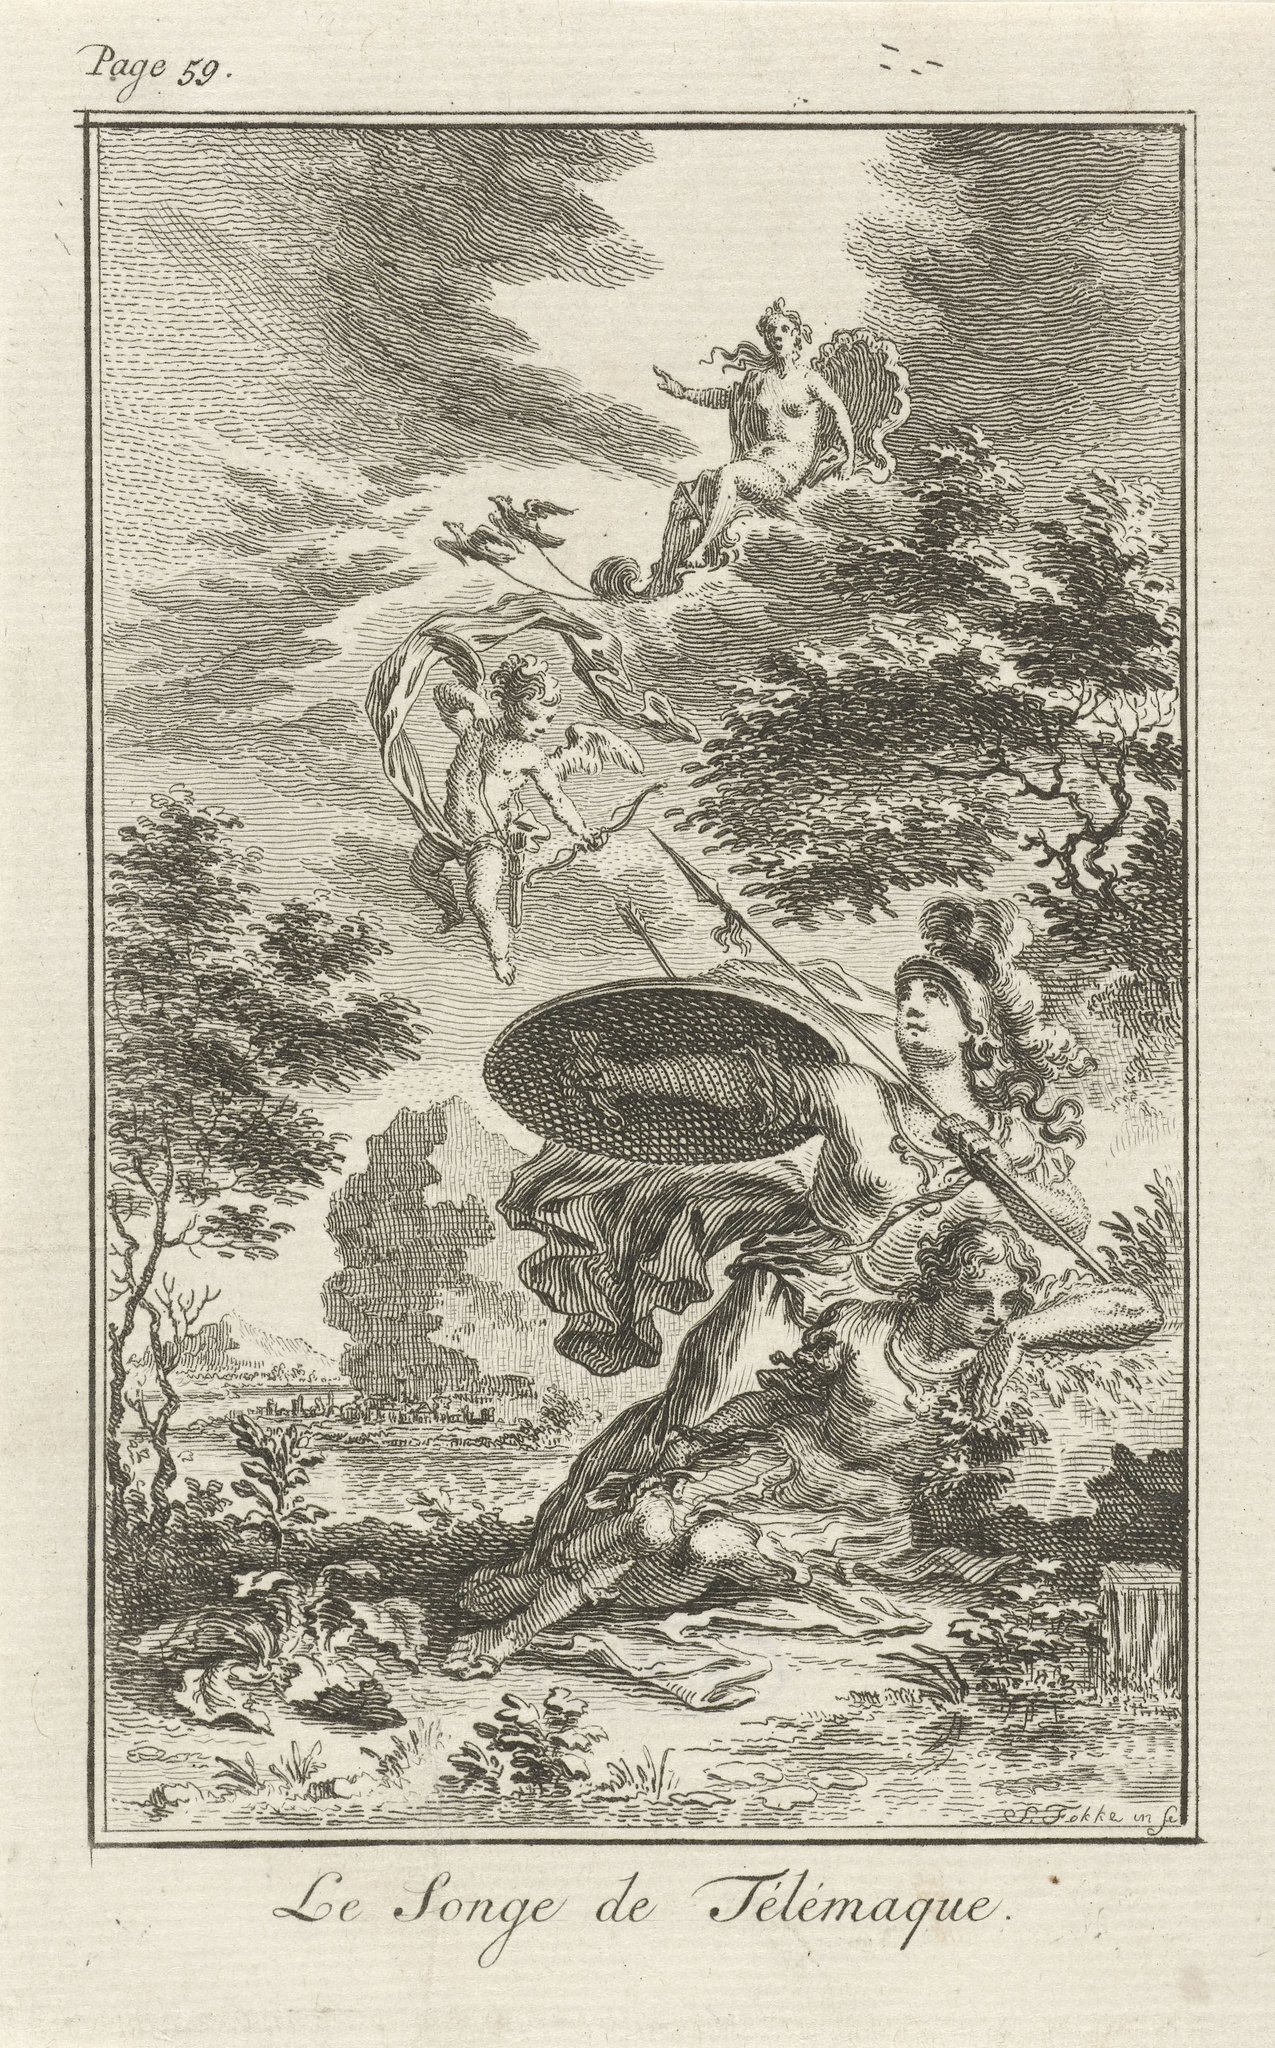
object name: book illustration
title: Minerva beschermt Telemachus tegen pijlen van Amor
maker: simon fokke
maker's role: draughtsman, print maker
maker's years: 1712-1784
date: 1775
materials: paper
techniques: etching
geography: amsterdam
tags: sleeping; unconsciousness - bb - out of doors, (story of) minerva (pallas, athena), (story of) venus (aphrodite), (story of) telemachus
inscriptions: collector's mark: Lugt 2228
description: Minerva houdt haar schild boven Telemachus om te voorkomen dat de pijlen van Amor hem kunnen raken. In de lucht rust Venus op een door duiven voortgetrokken schelp. Prent linksboven gemerkt: Page 63.